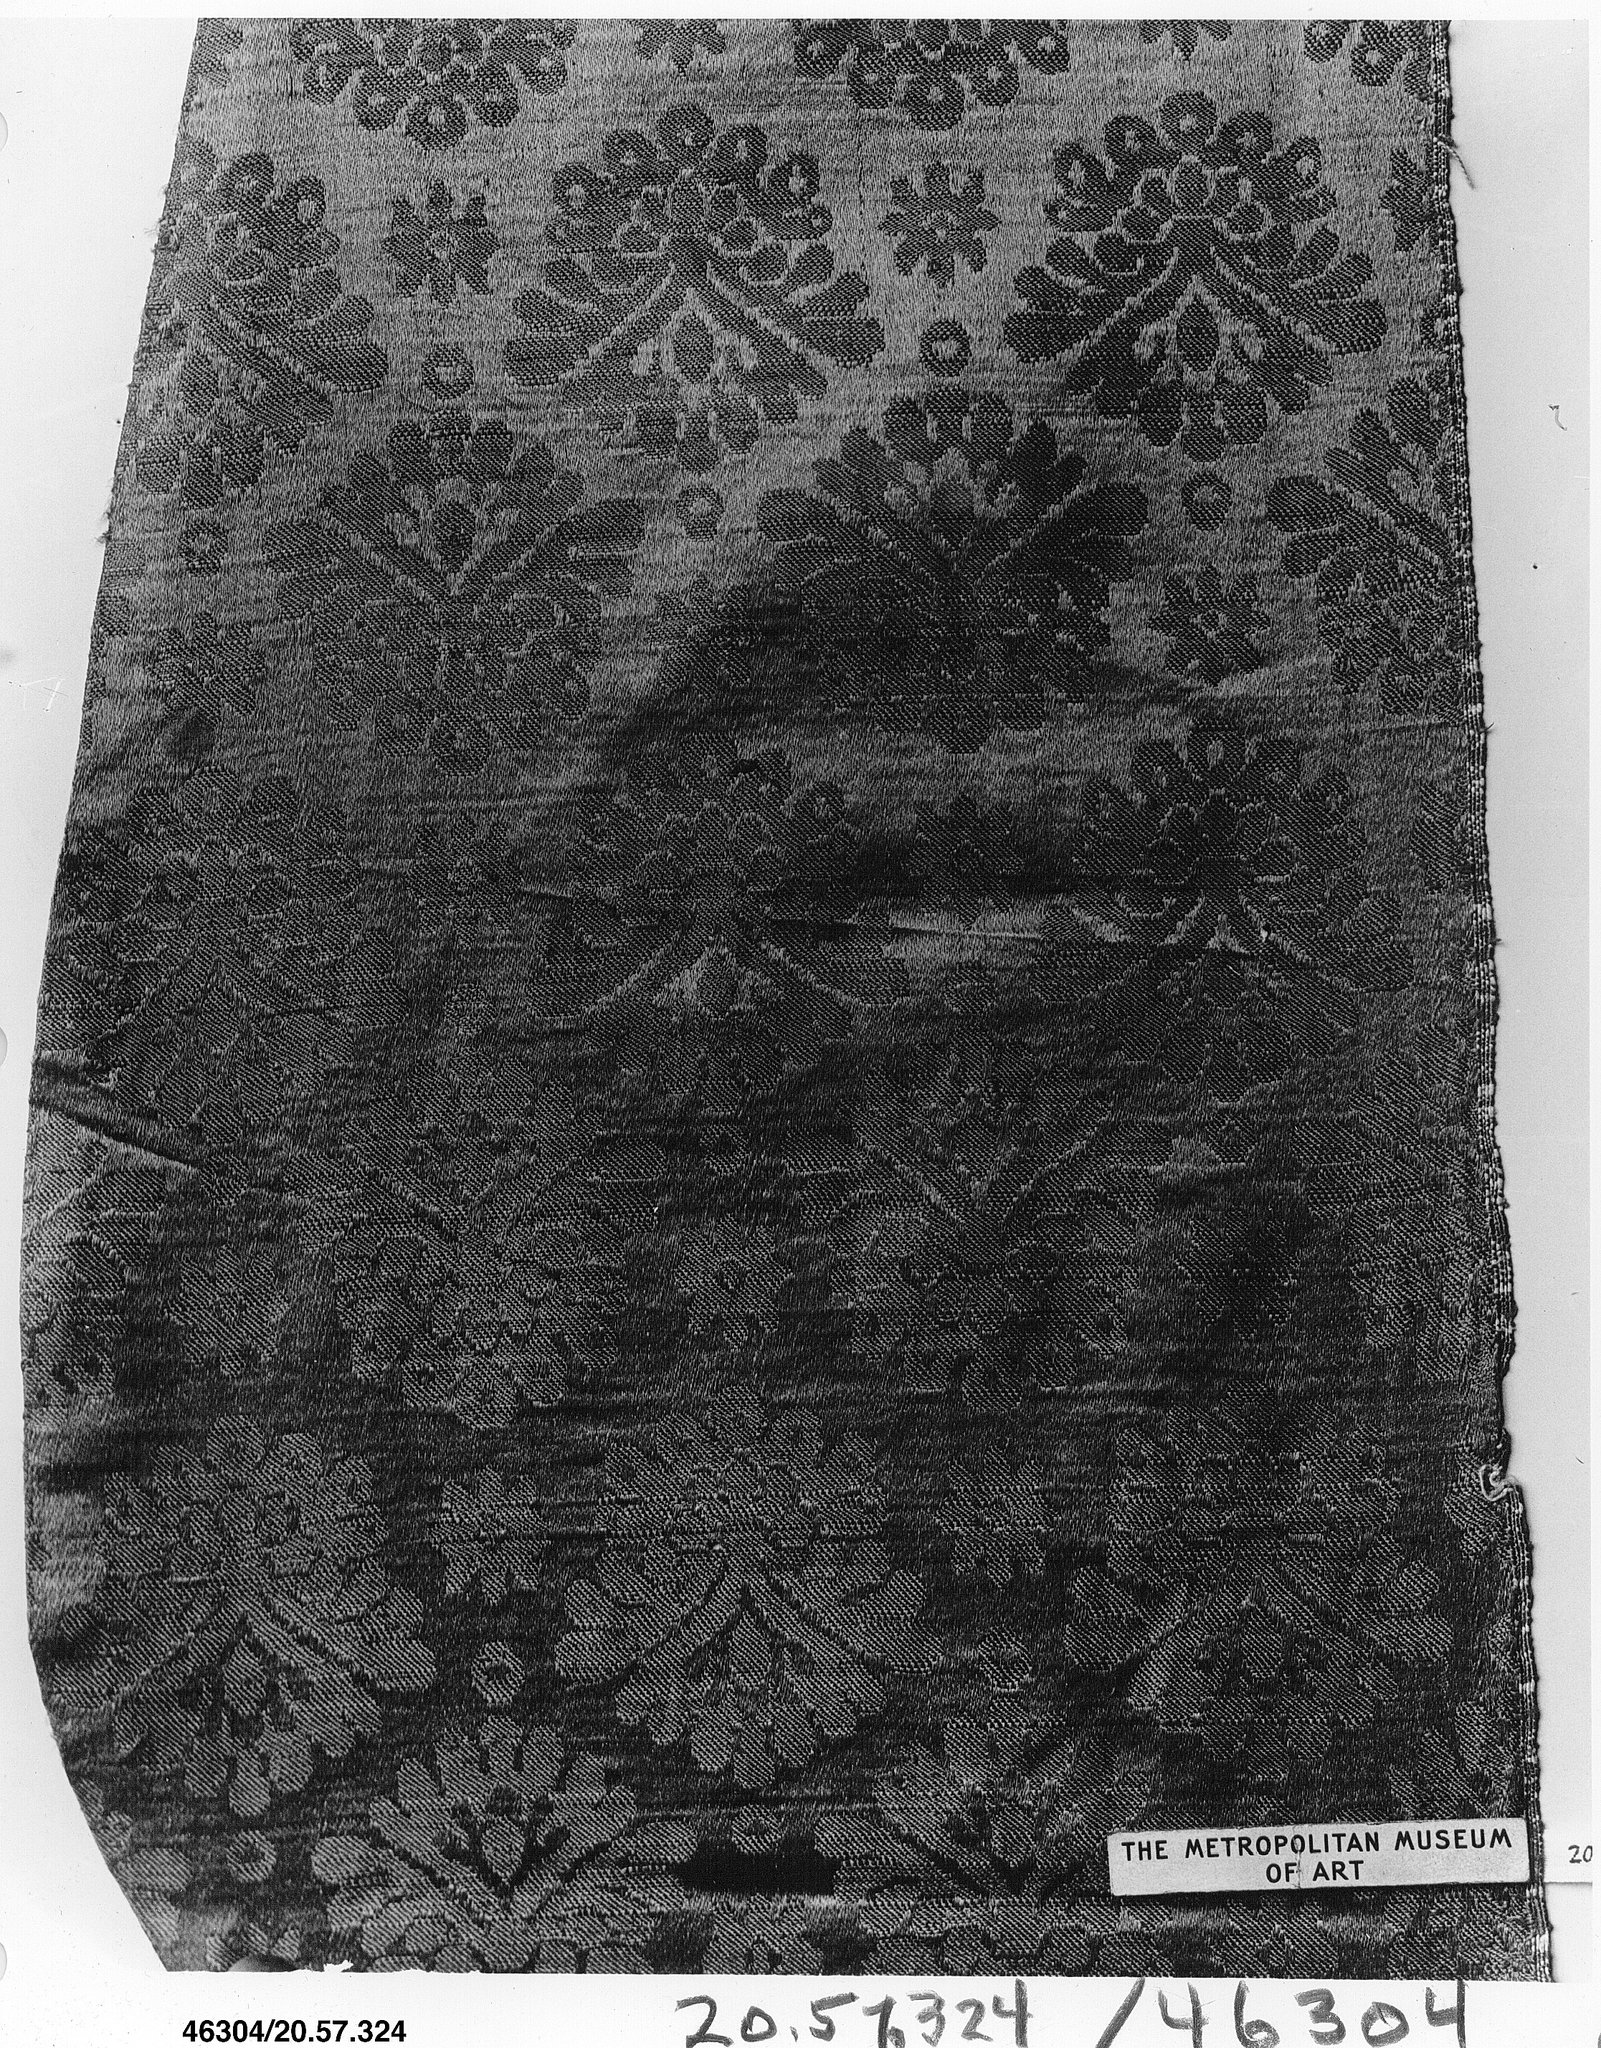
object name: piece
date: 1601-1633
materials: silk